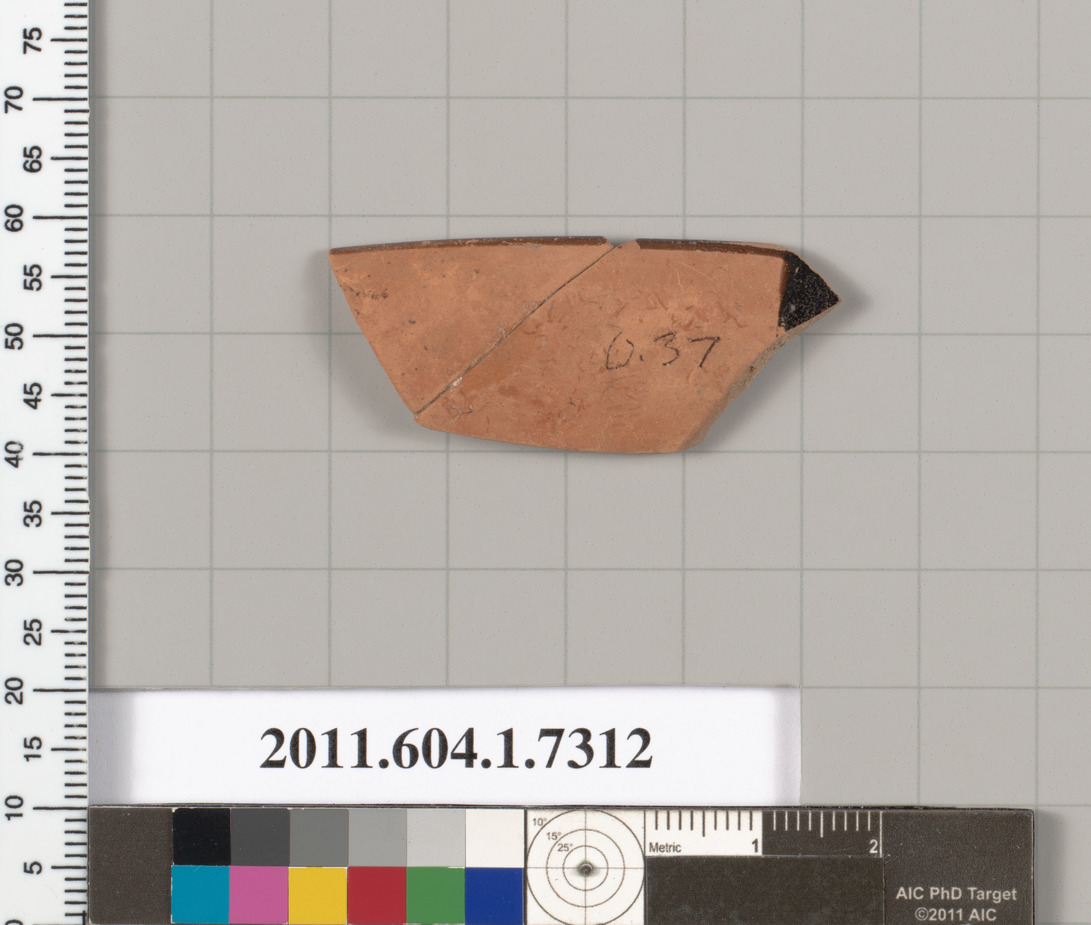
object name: kylix fragment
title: Terracotta rim fragment of a kylix (drinking cup)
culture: greek, attic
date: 500-480 BCE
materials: terracotta